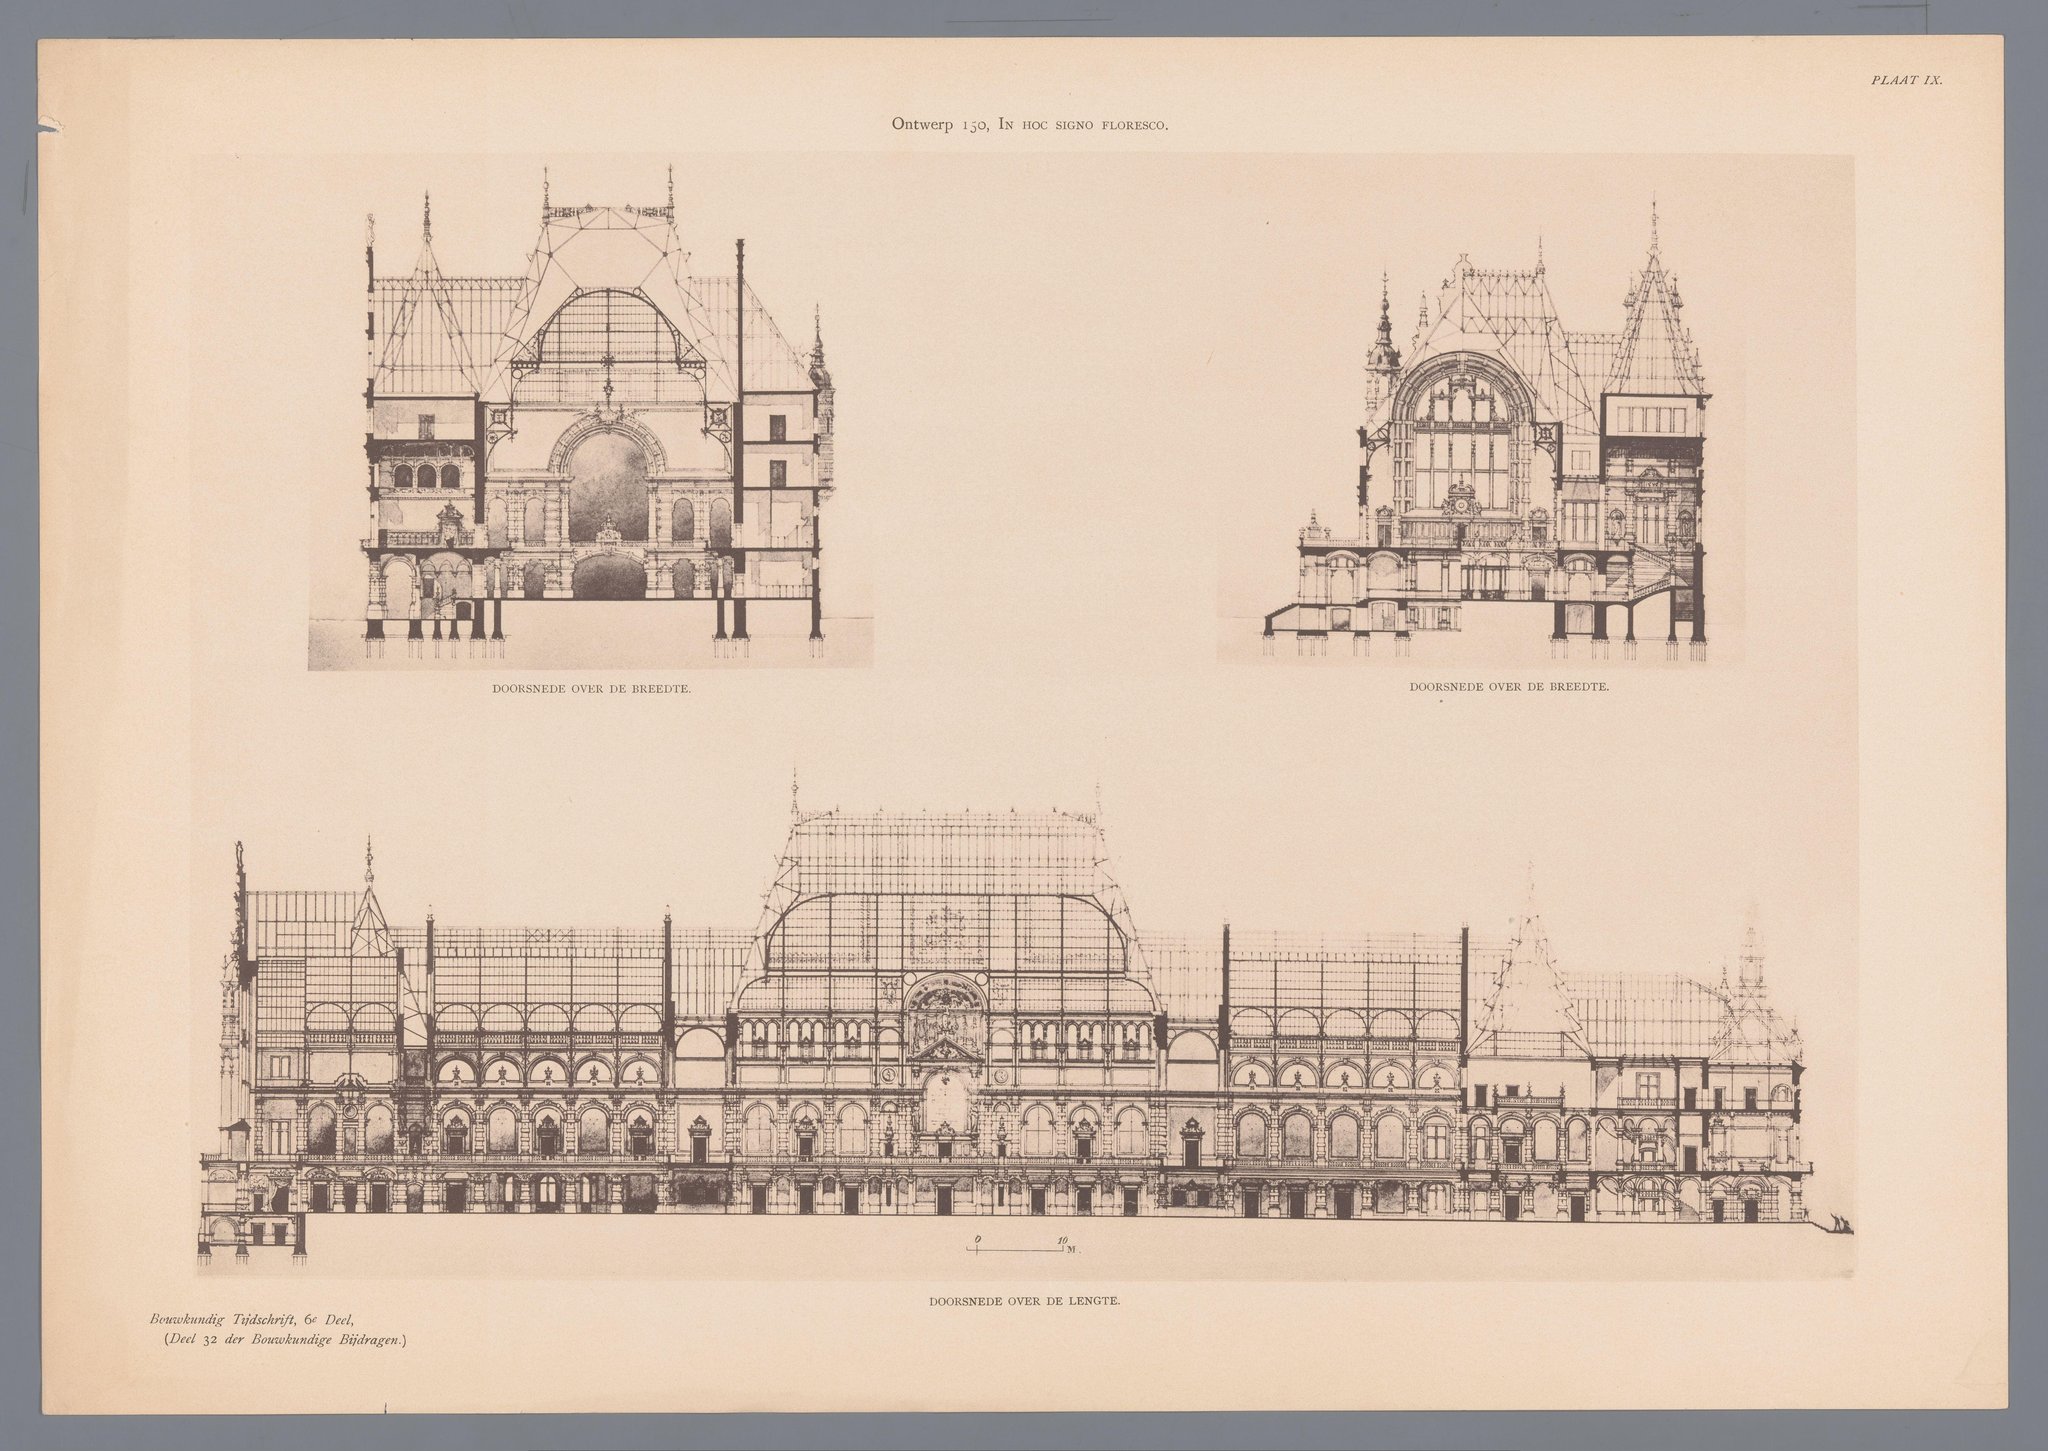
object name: book illustration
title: Ontwerp voor een nieuw beursgebouw in Amsterdam: doorsneden van ontwerp 150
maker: Anonymous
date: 1886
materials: paper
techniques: photograph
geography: amsterdam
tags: market-hall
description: Prent uit: Bouwkundig tijdschrift 6, deel 32 der bouwkundige bijdragen (1886), pl. 9.